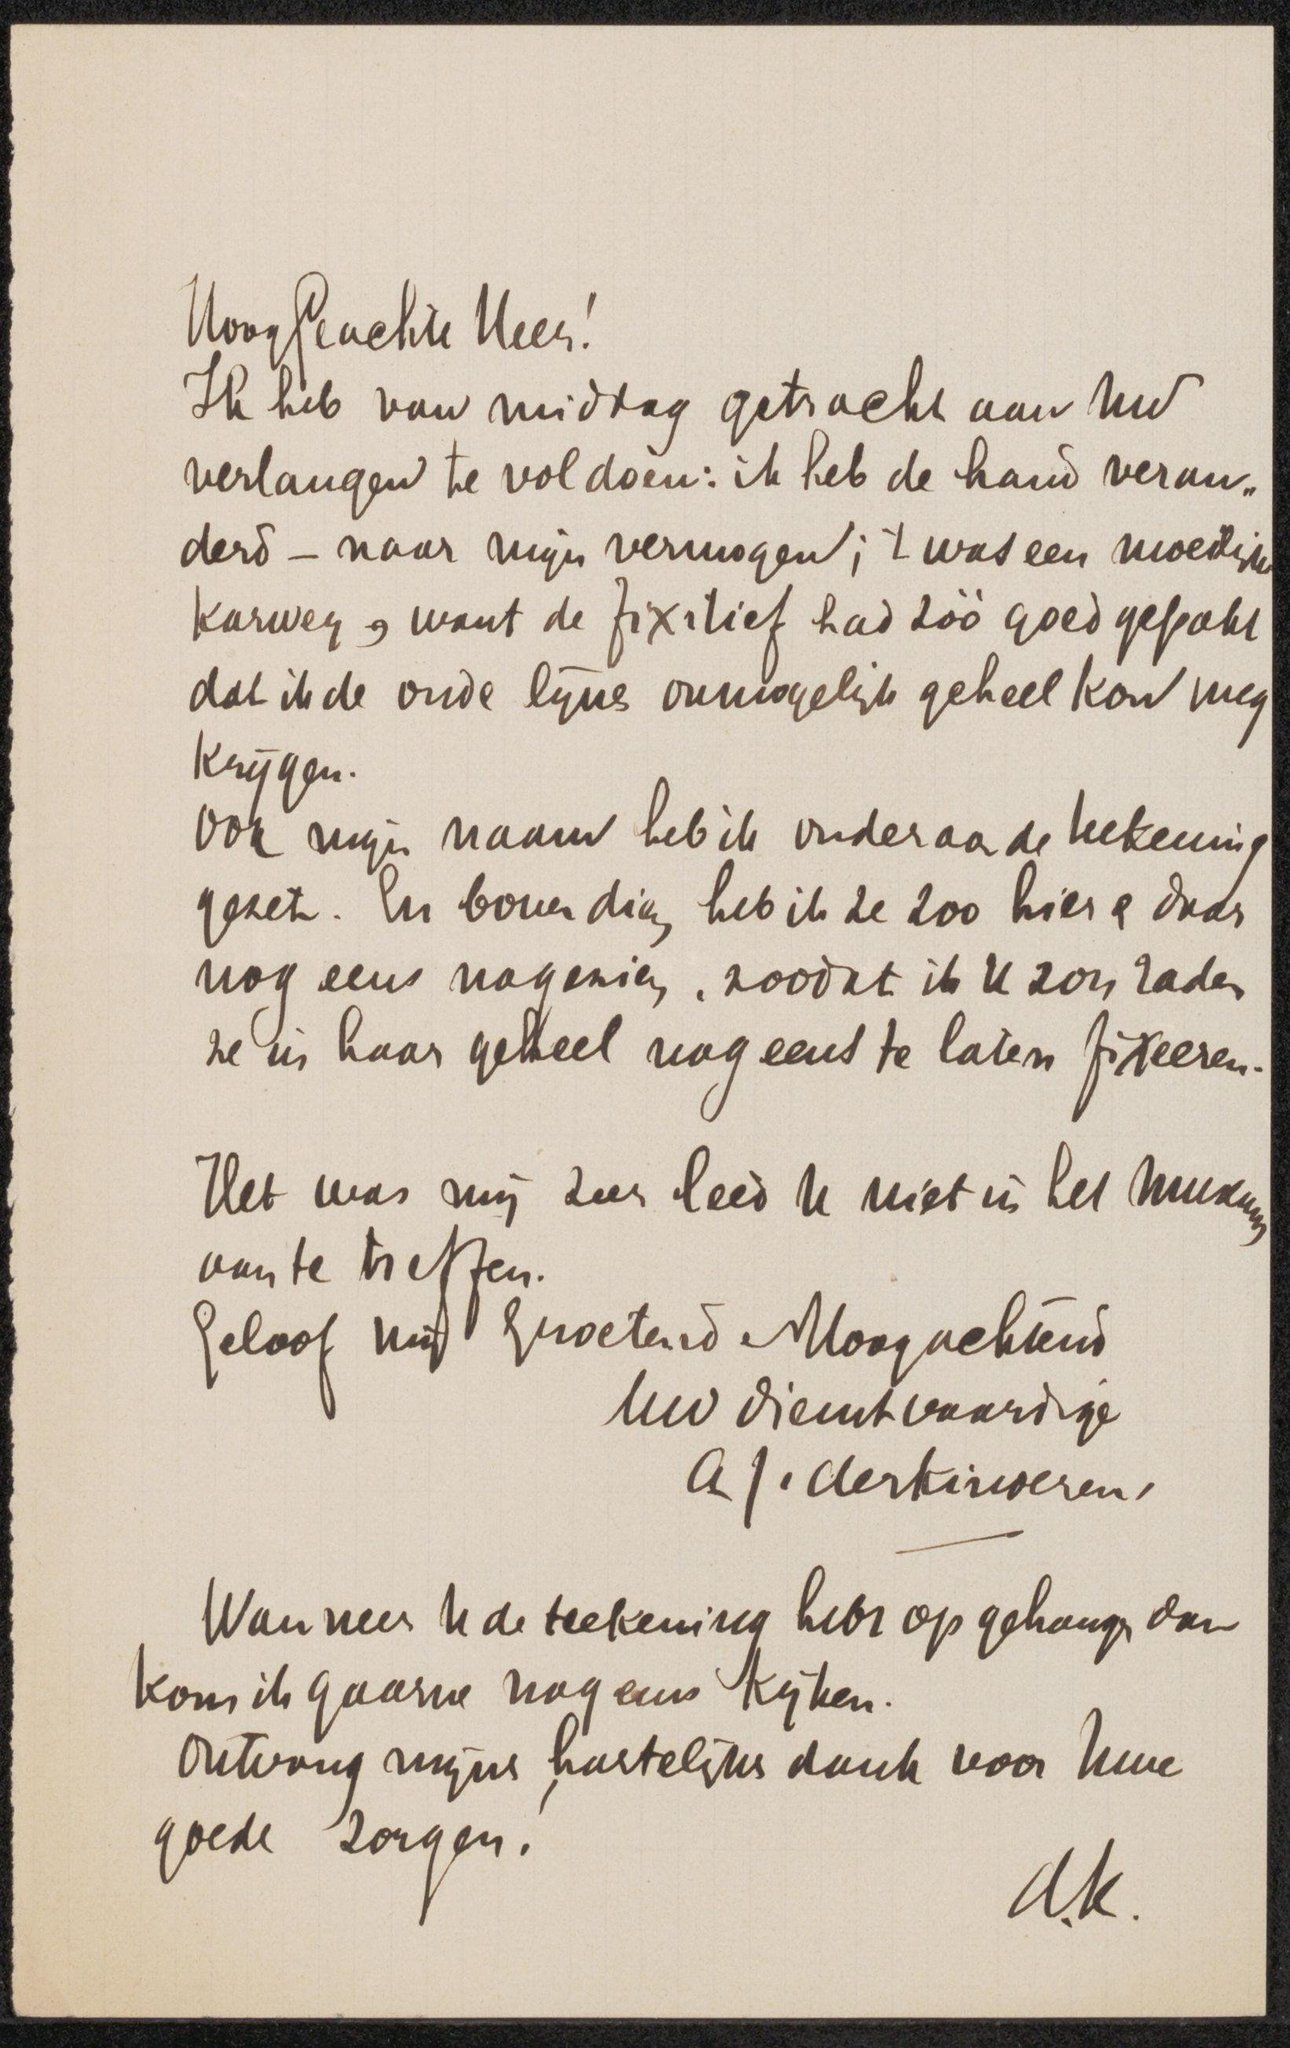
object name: letter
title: Brief aan Pieter Haverkorn van Rijsewijk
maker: antoon derkinderen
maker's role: draughtsman, painter, print maker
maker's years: 1859-1925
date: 1869-1915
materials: ink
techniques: pen, writing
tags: pieter haverkorn van rijsewijk, drawing, exhibition ~ art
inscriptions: collector's mark: ‘PRK’